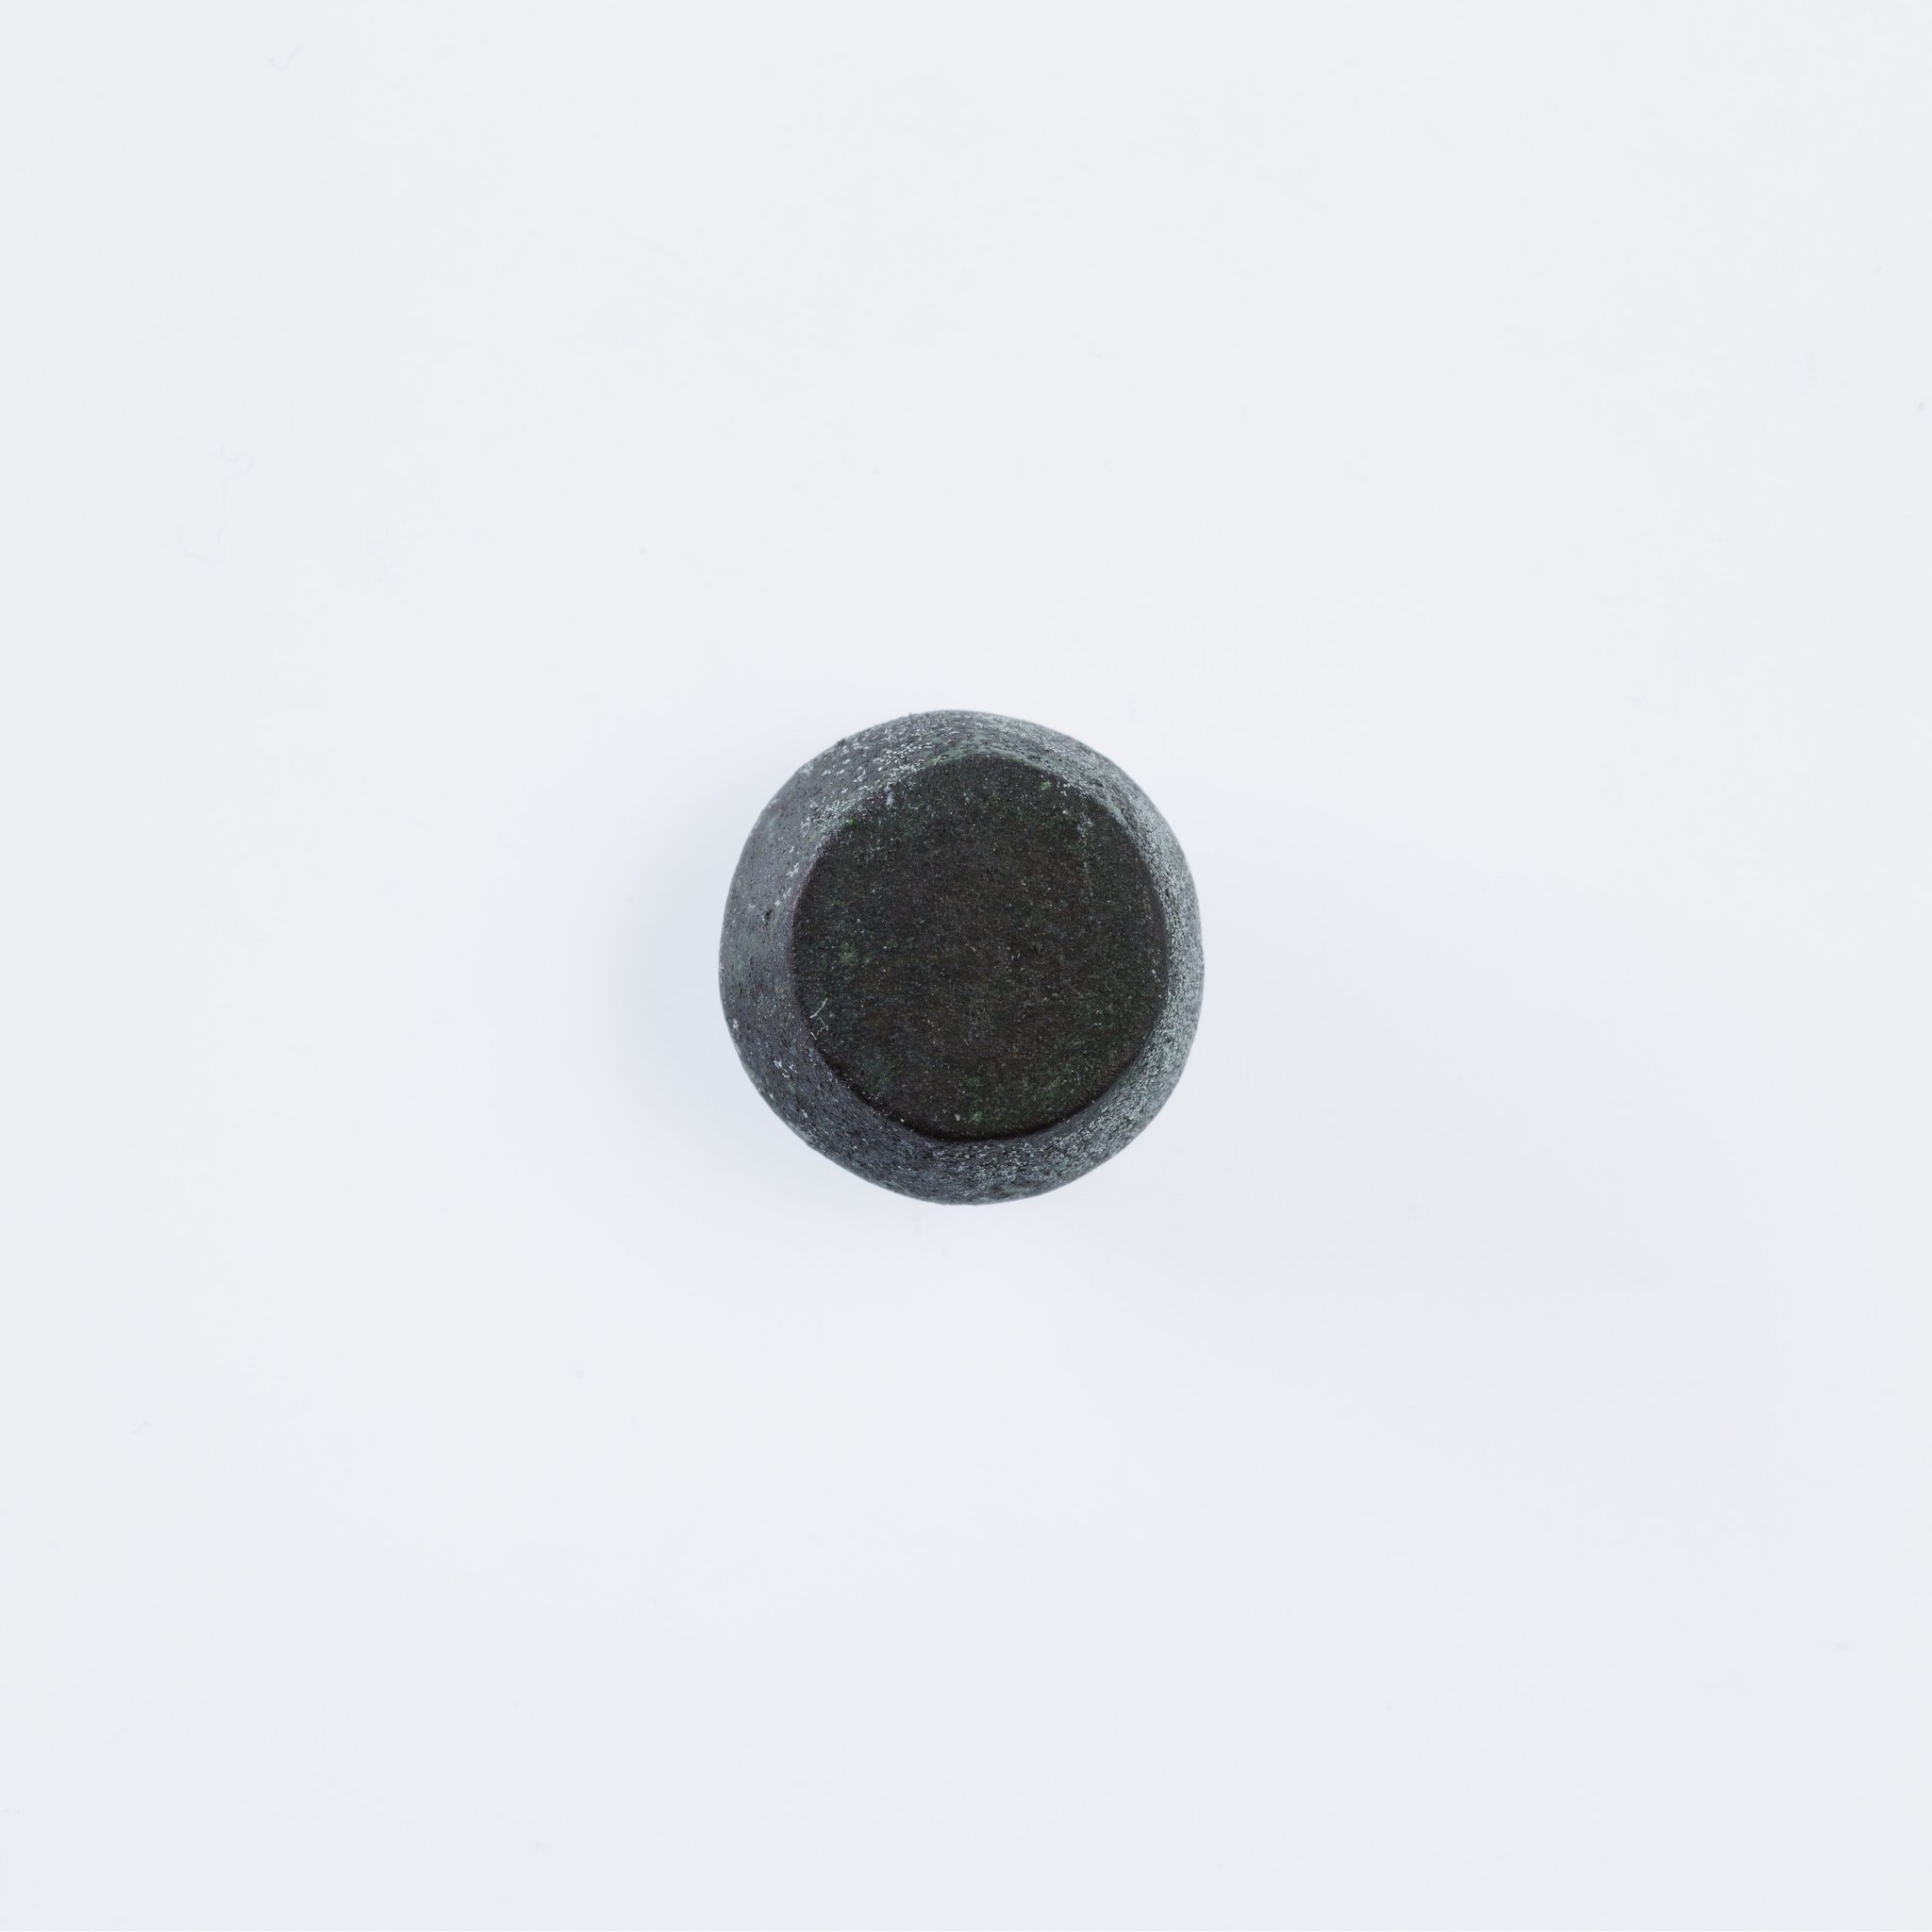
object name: weight, qedet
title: 1/4 Qedet weight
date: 664-630 BCE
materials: bronze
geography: egypt